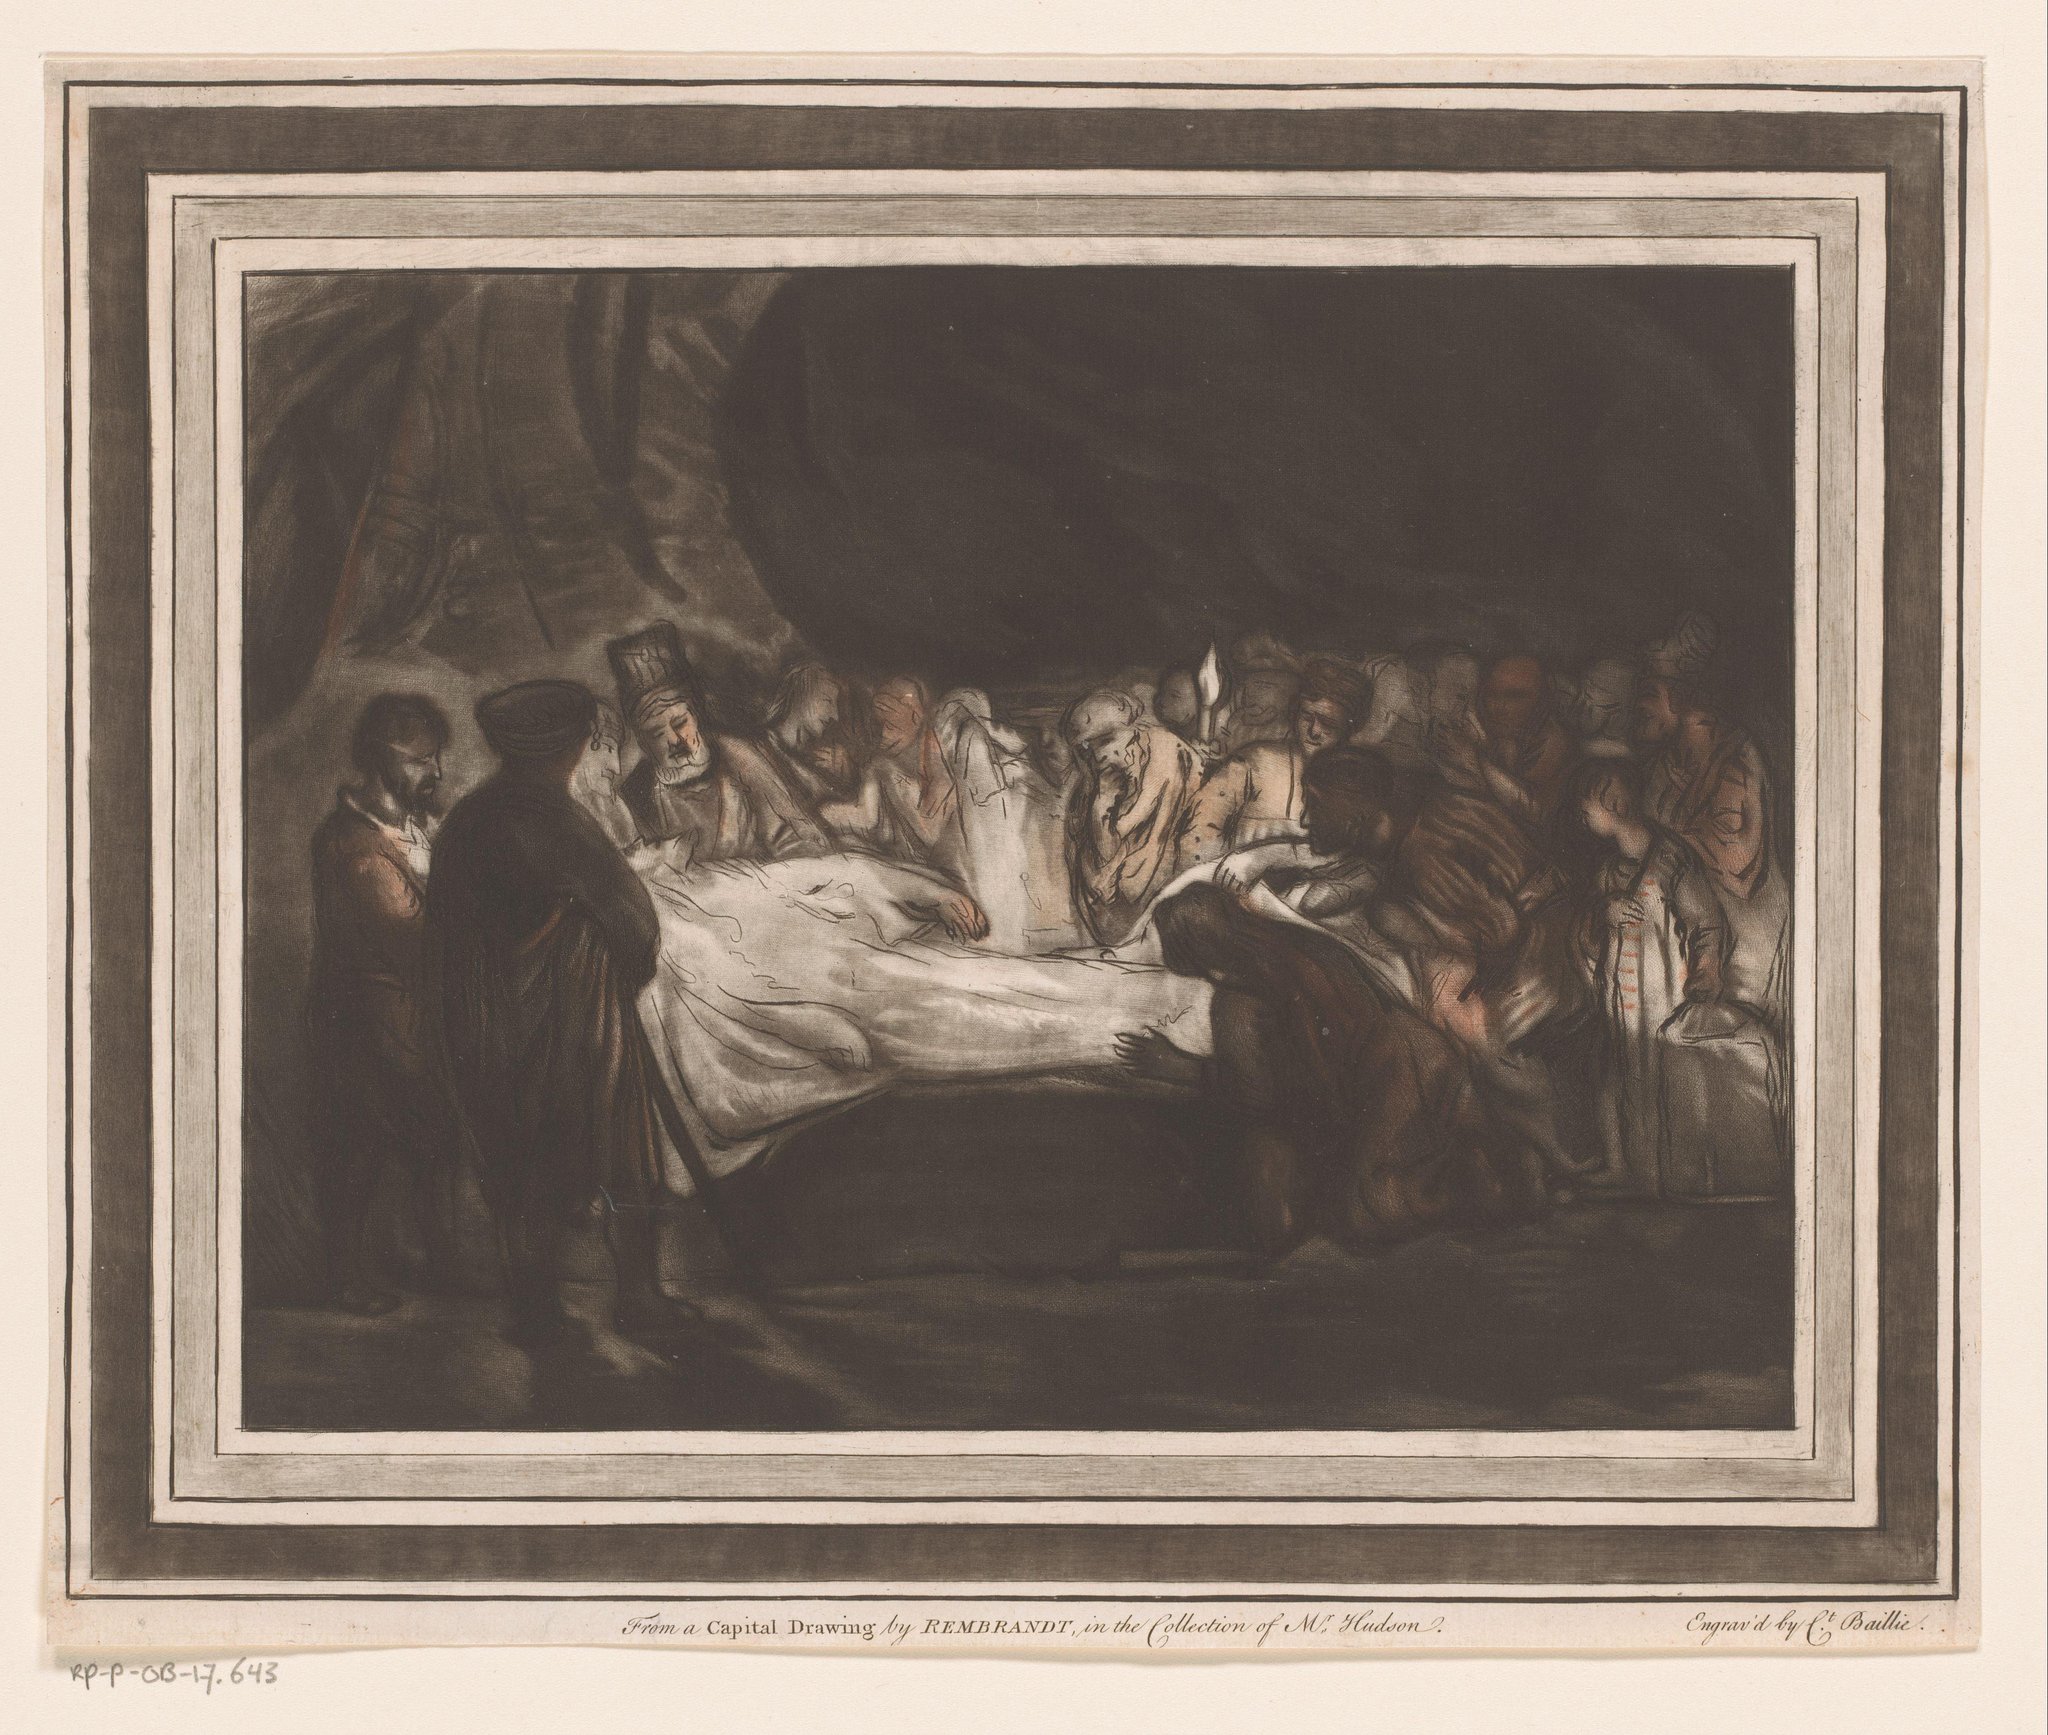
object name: print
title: Graflegging van Christus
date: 1750-1810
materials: paper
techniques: hand coloring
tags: christ's entombment (possibly by angels)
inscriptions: collector's mark: Lugt 2228, collector's mark: Lugt 3761